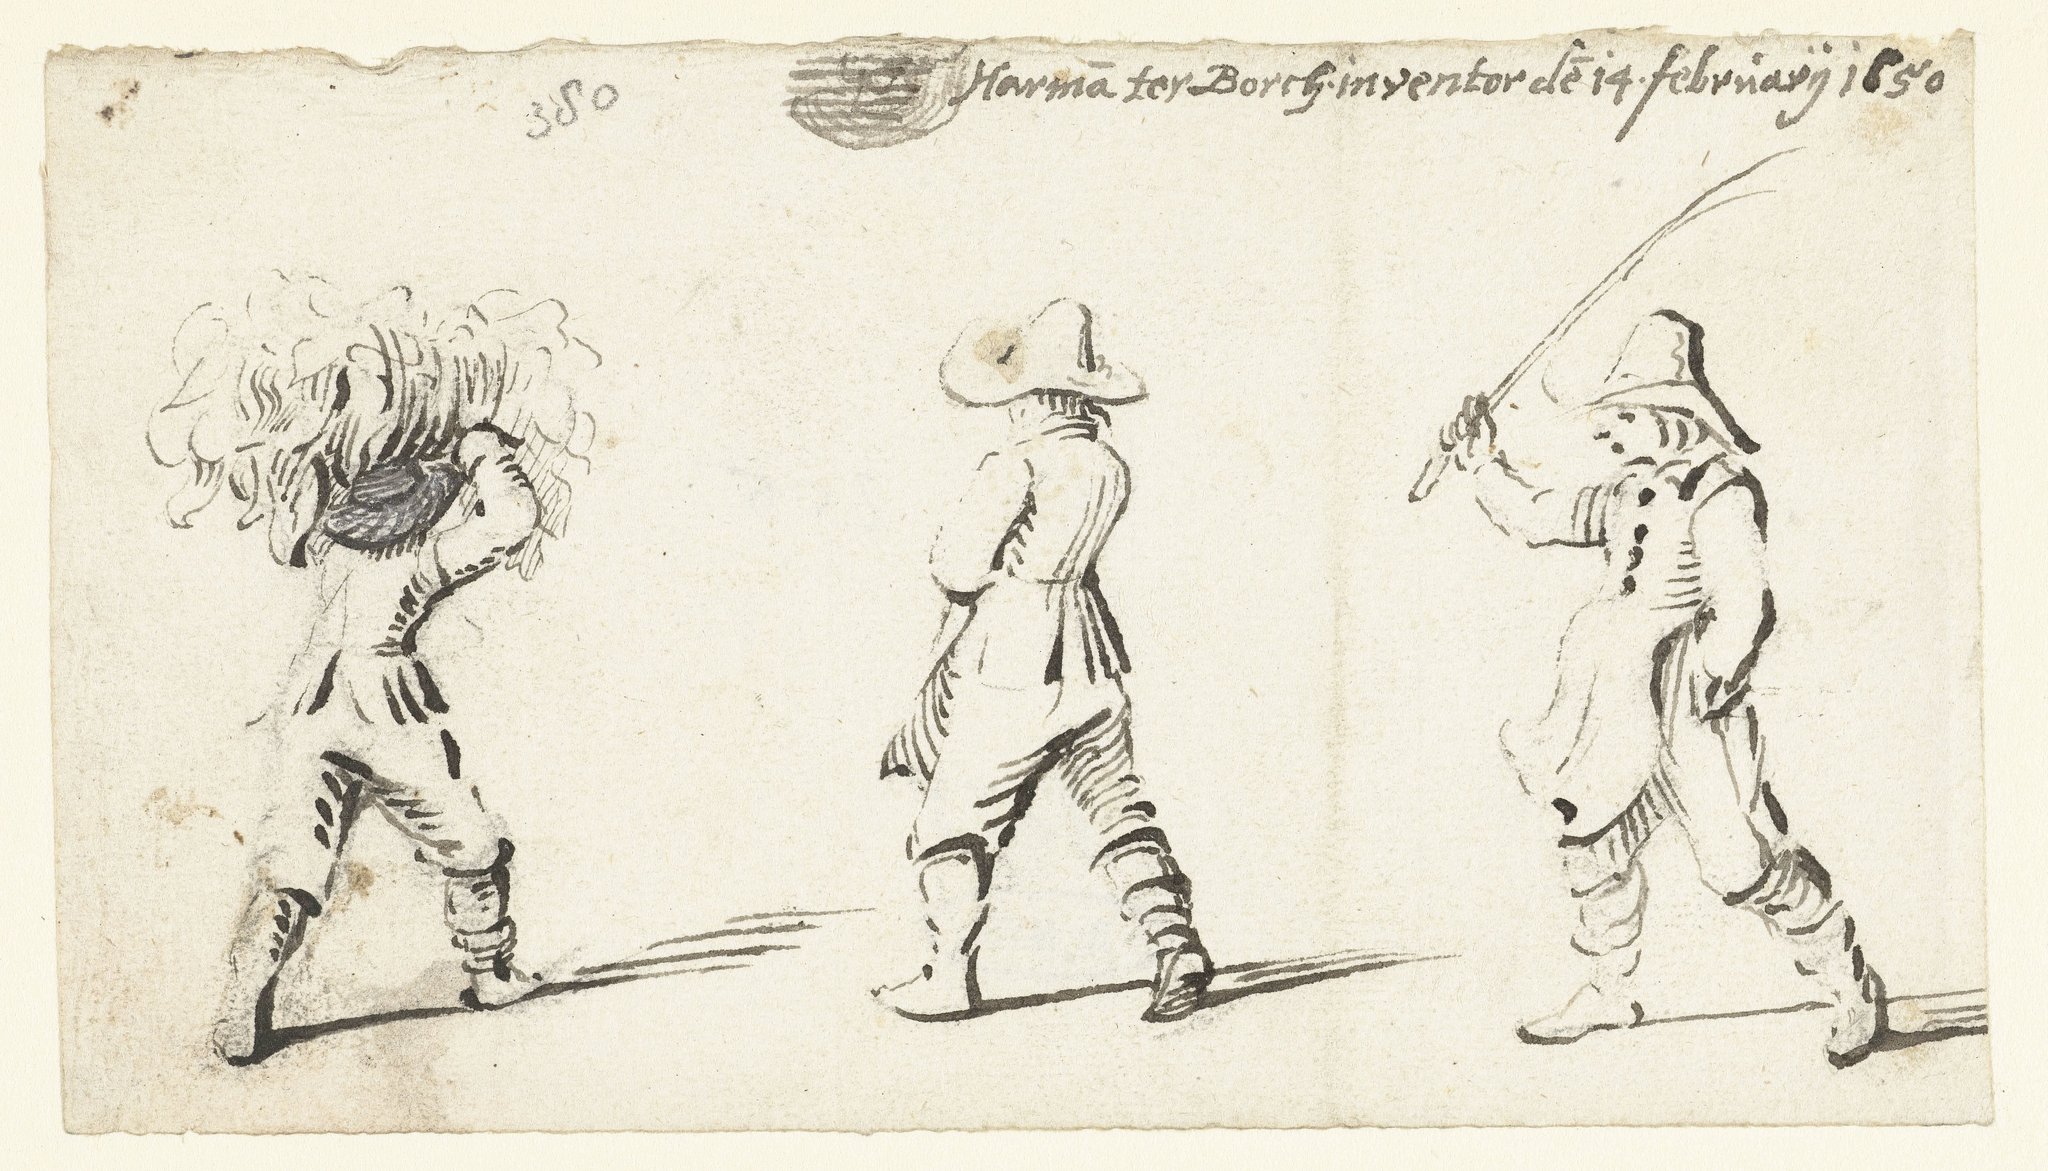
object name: drawing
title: Studieblad met drie lopende figuren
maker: harmen ter borch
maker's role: draughtsman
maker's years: 1638-1677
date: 1650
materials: chalk, ink, paper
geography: zwolle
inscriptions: annotation: ‘Harma[n] ter Borch. inventor de[n] 14.februarij 1650’